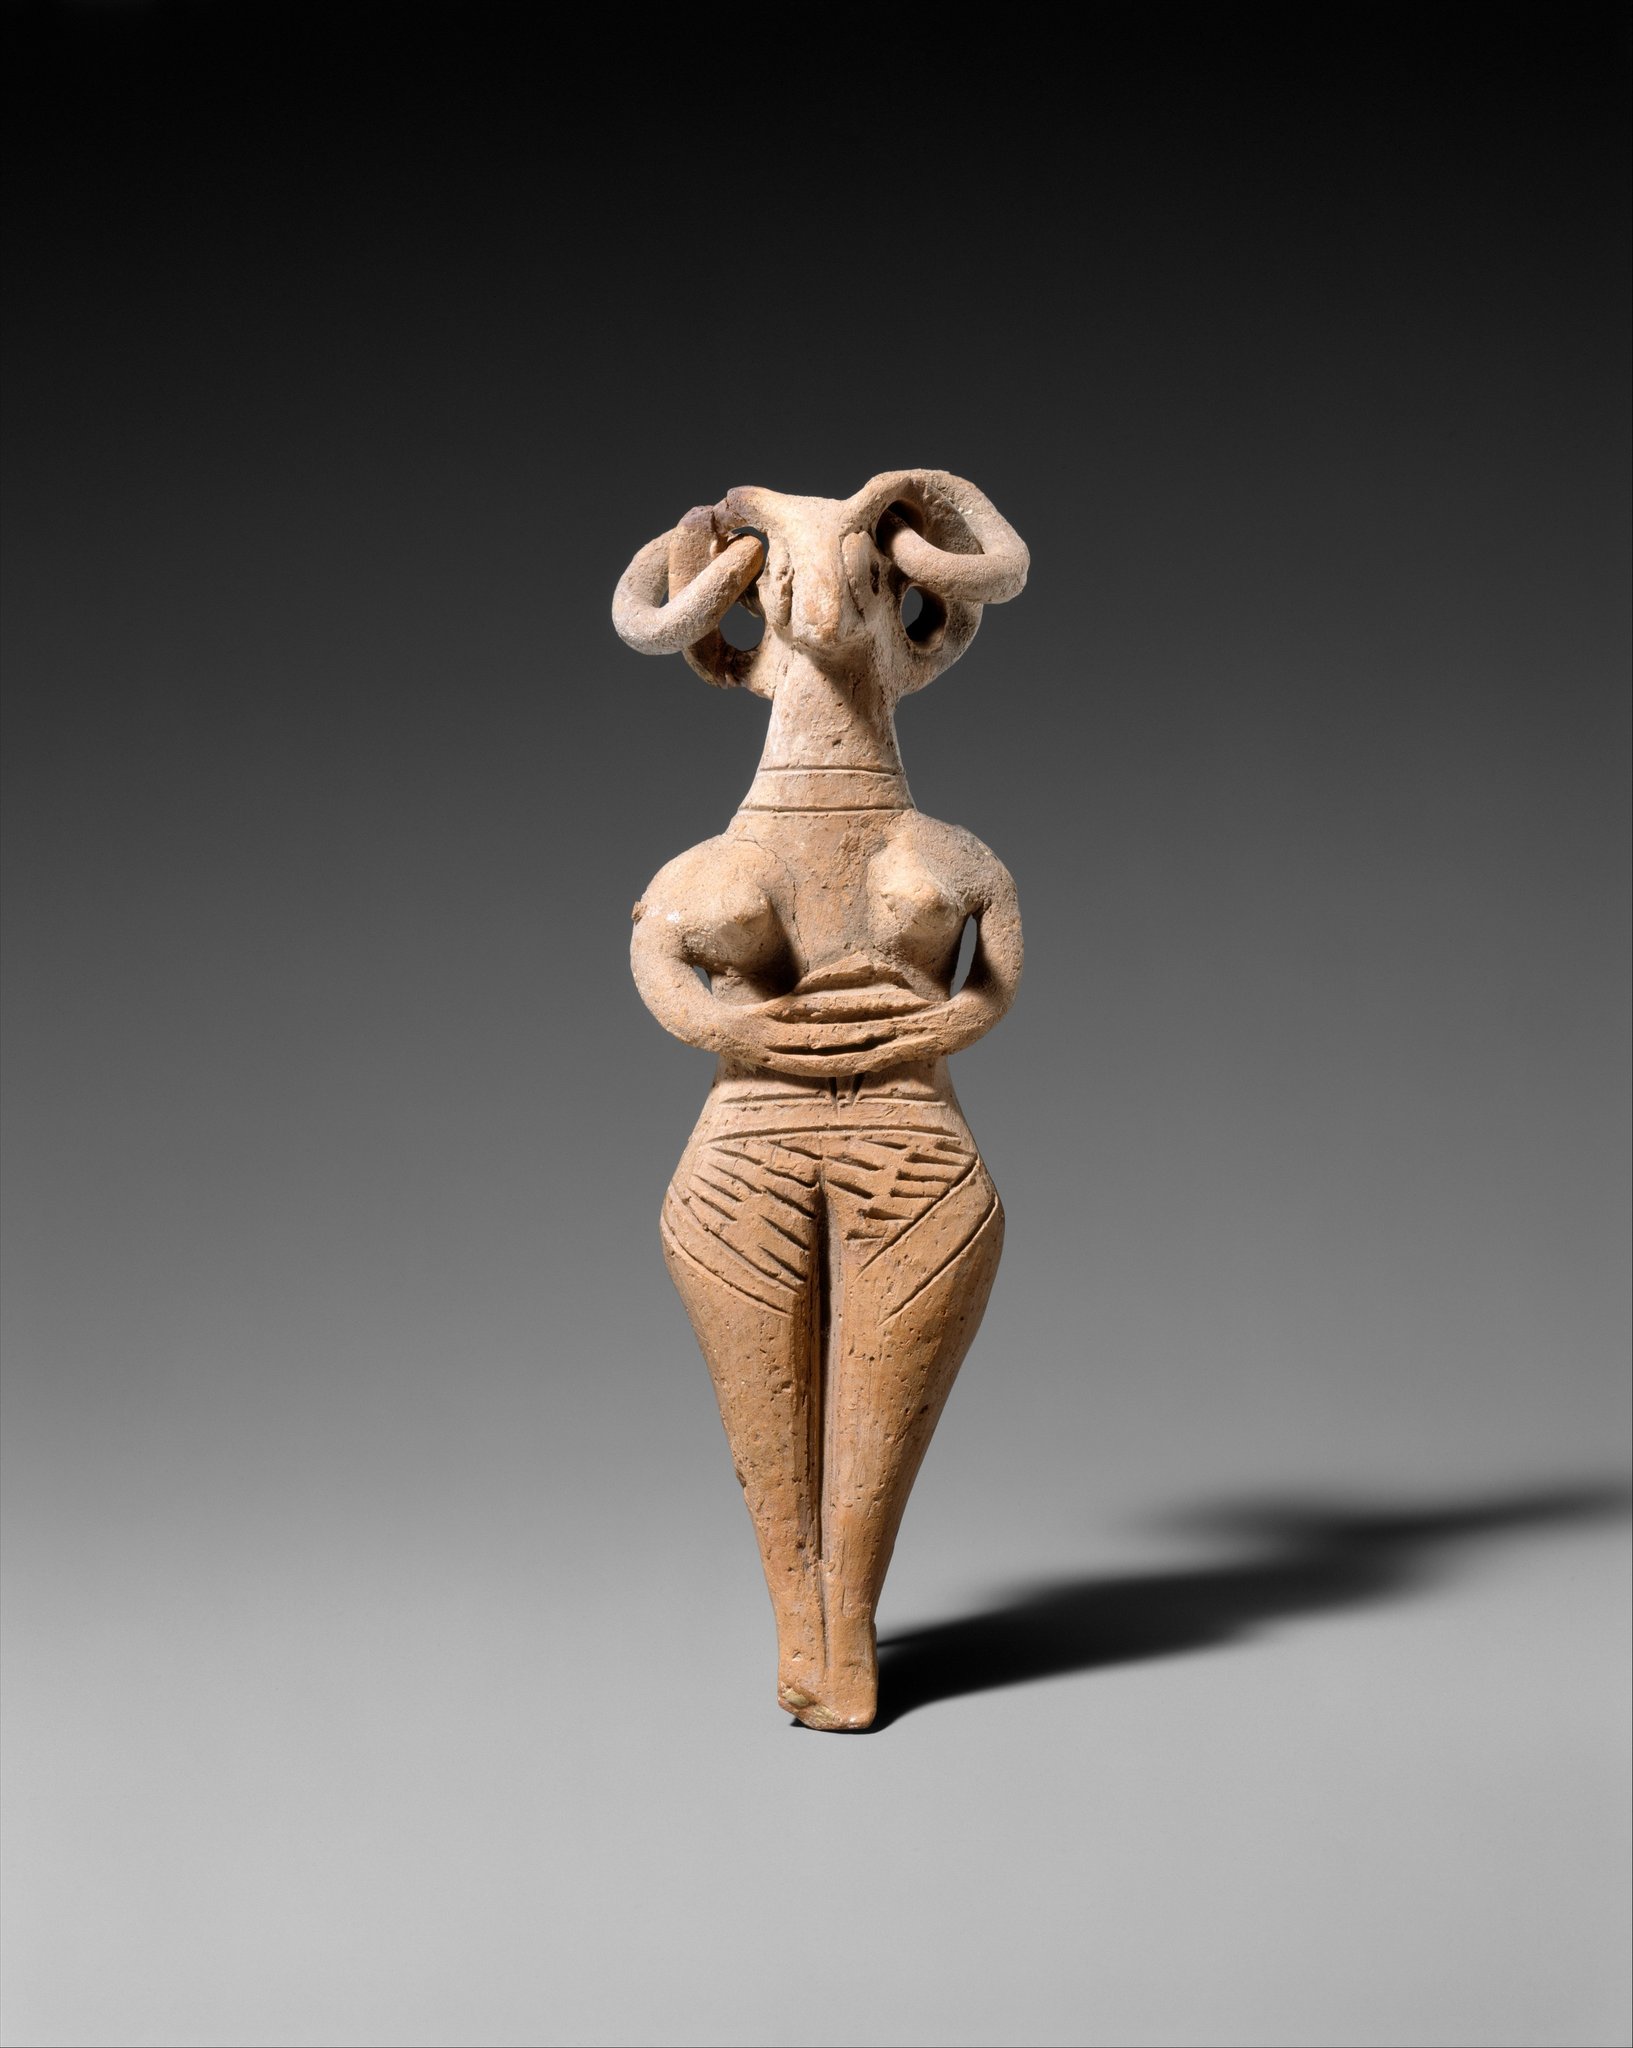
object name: statuette of a woman with bird face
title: Terracotta statuette of woman with bird face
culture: cypriot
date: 1450-1200 BCE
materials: terracotta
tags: birds,women